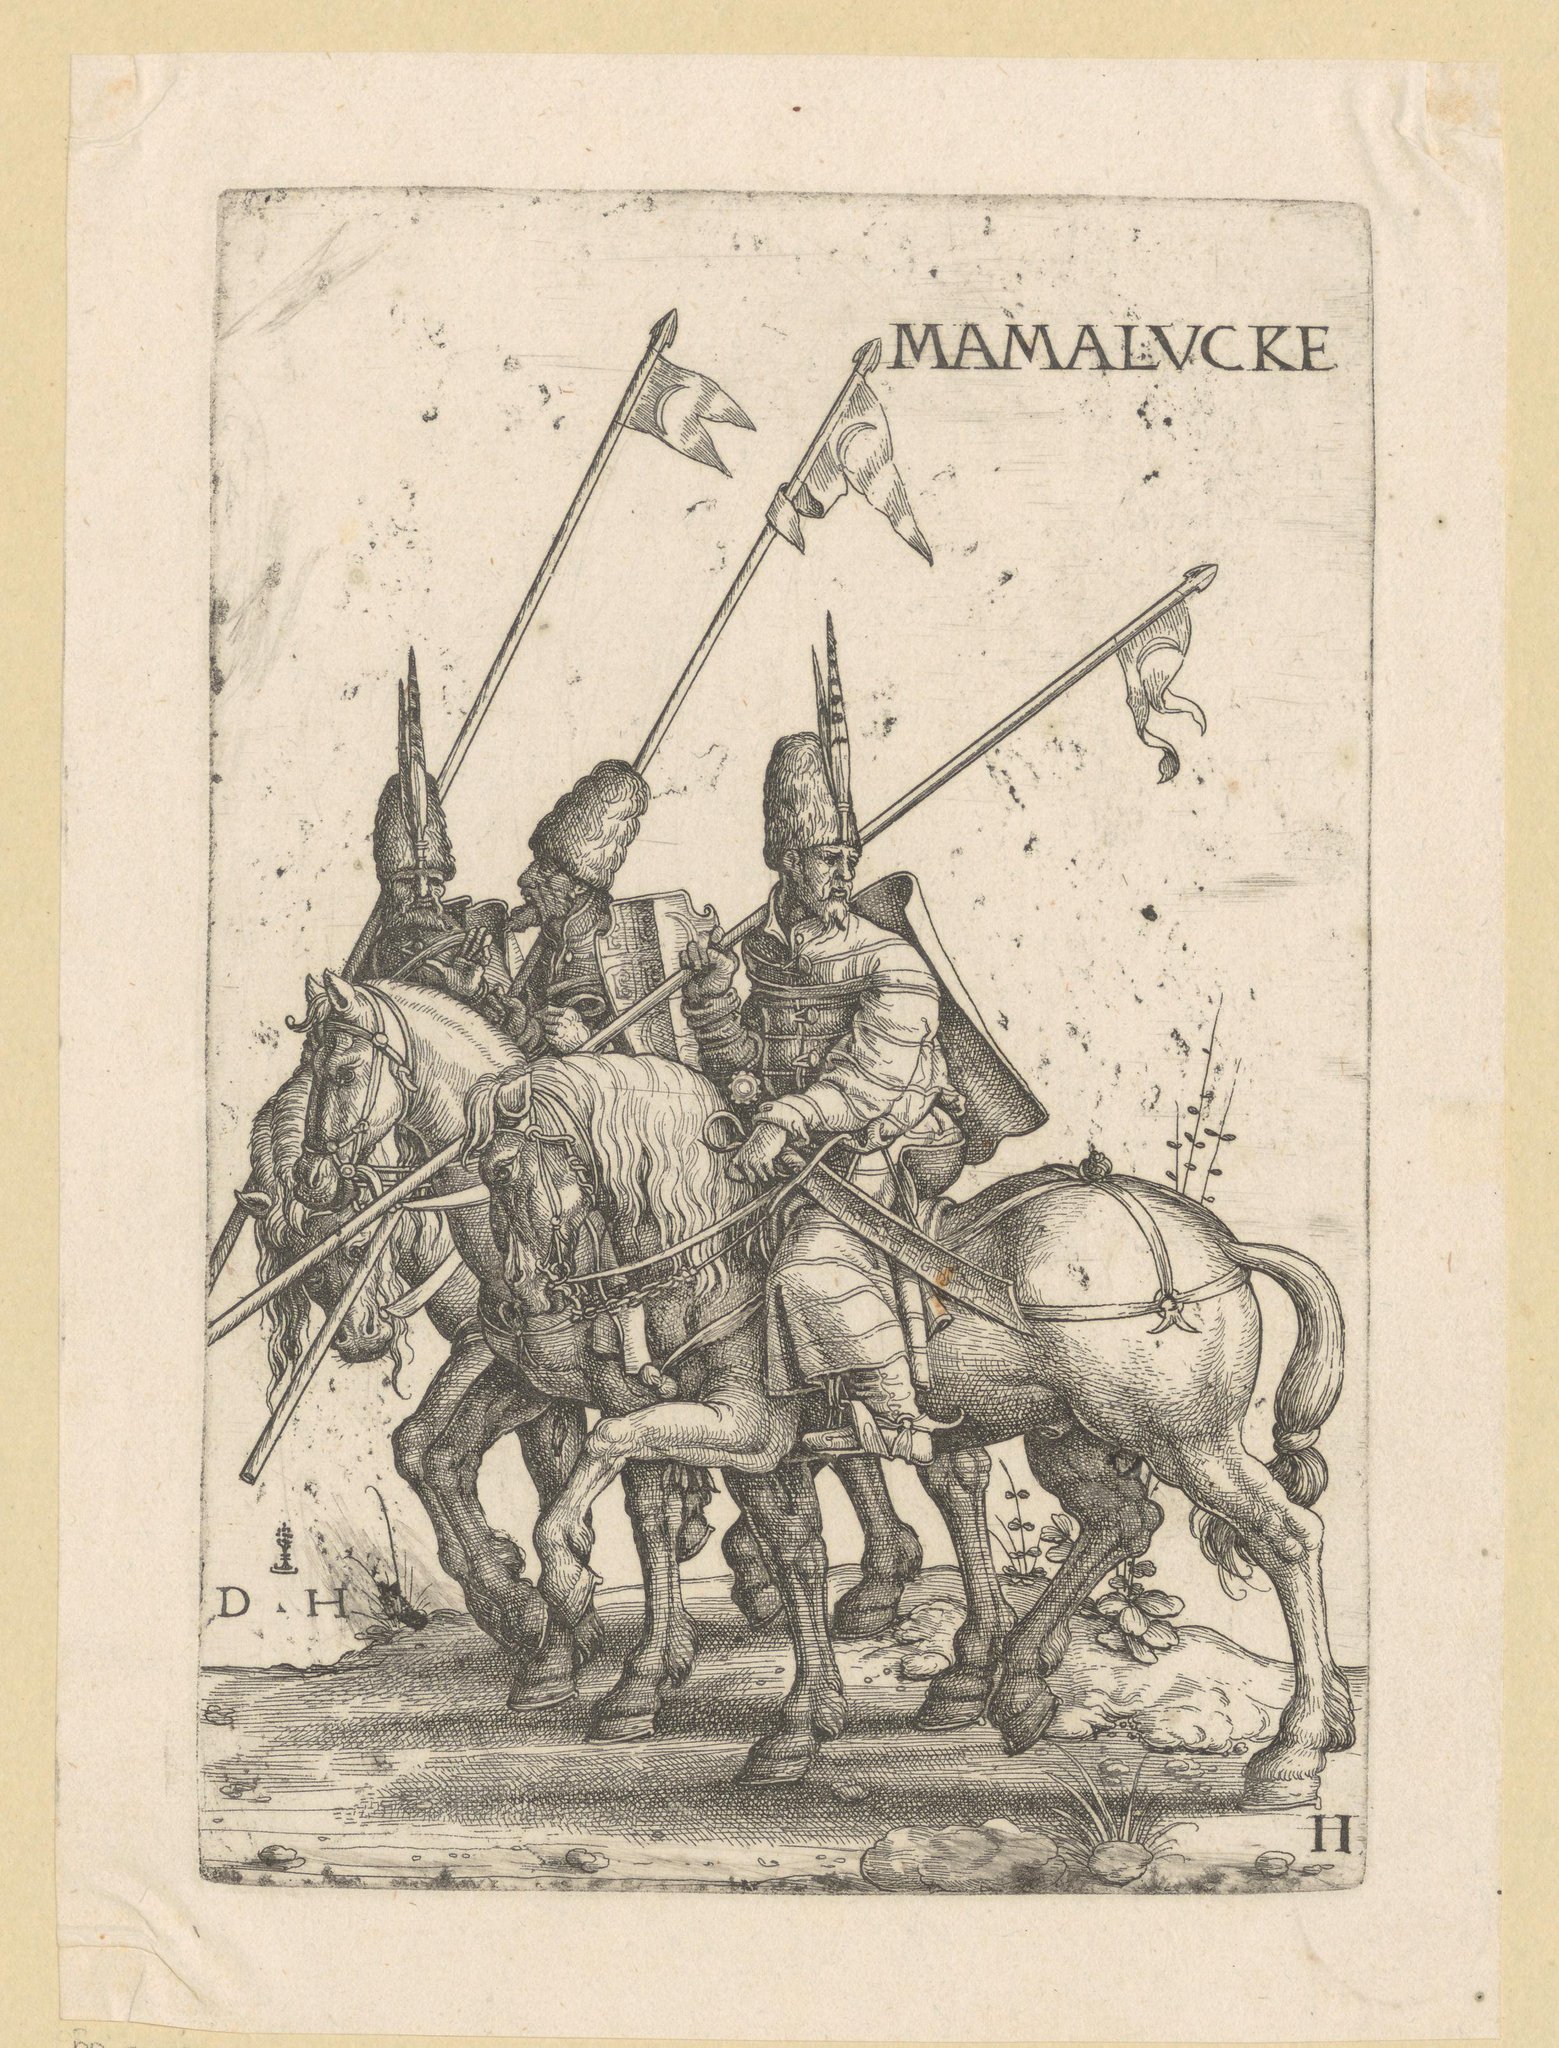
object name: print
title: Mamalucke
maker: daniel hopfer (i)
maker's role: print maker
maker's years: 1470-1536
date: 1530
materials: paper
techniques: etching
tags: triumphal entry and public reception, pageant, 'entrée solennelle', 'joyeuse entrée', military parade, pageant, (military) uniforms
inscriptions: collector's mark: Lugt 240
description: Deze prent is onderdeel van een serie naar Jan Swart's ontwerp uit 1526 met vijf prenten van Kanu Sultan Süleyman en zijn cortège, getiteld 'Soleiman de Grote en Turkse ruiters'.